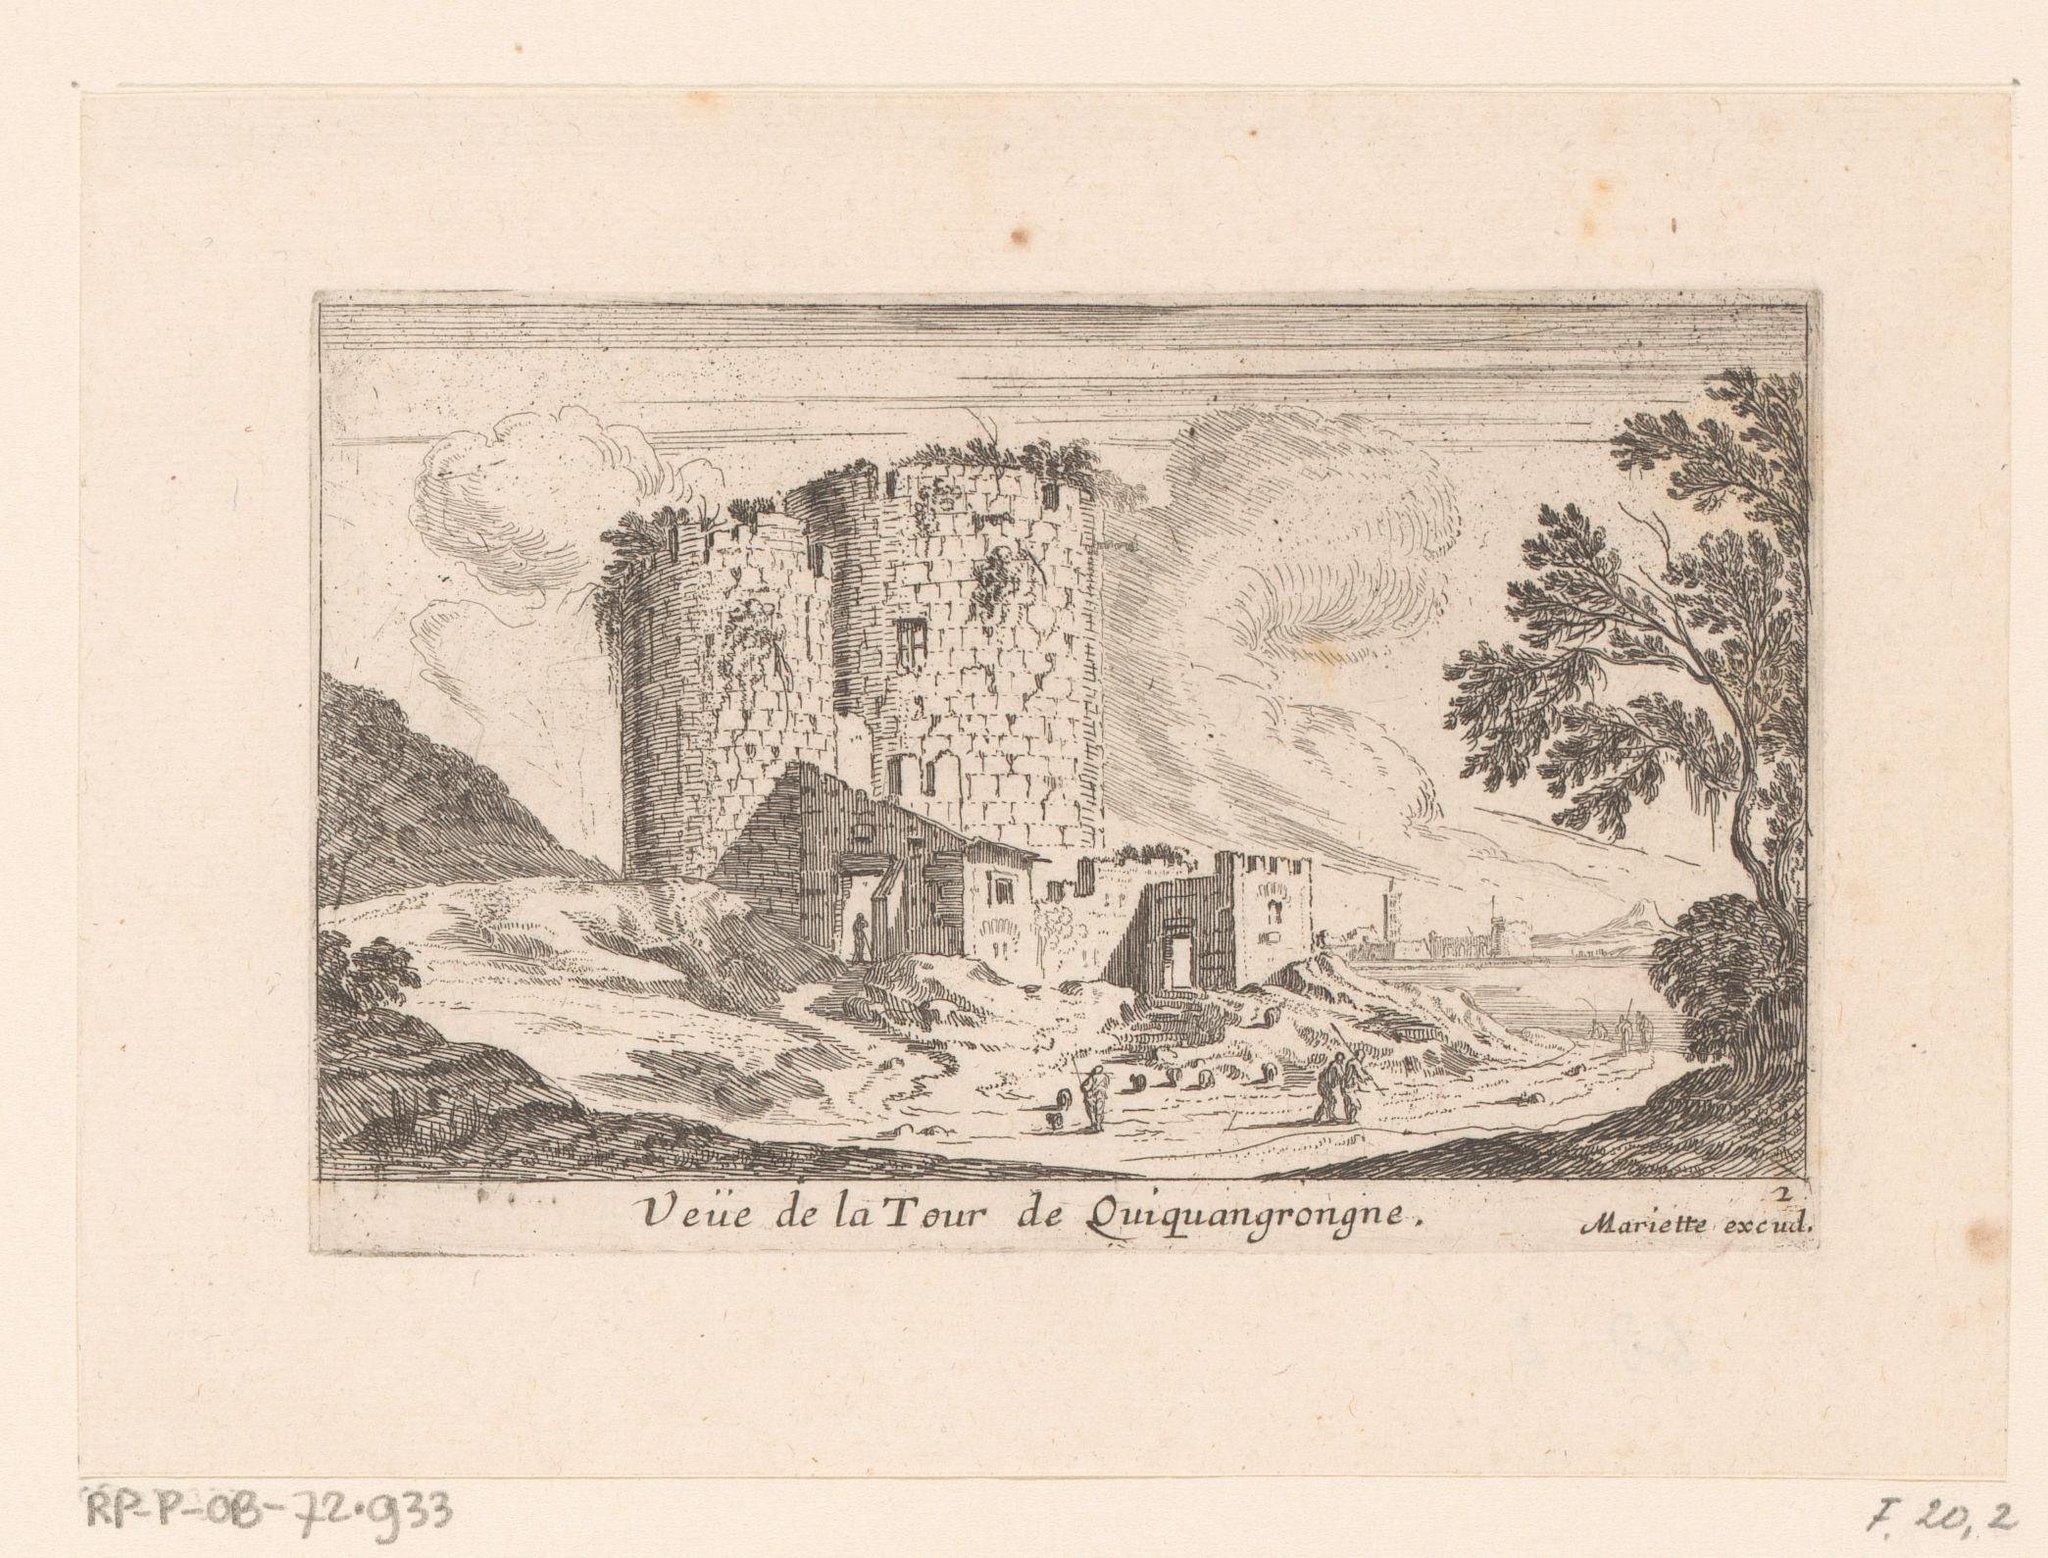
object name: print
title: Veue de la Tour de Quiquangrongne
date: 1631-1657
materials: paper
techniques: etching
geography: france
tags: landscape with tower or castle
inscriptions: collector's mark: Lugt 240